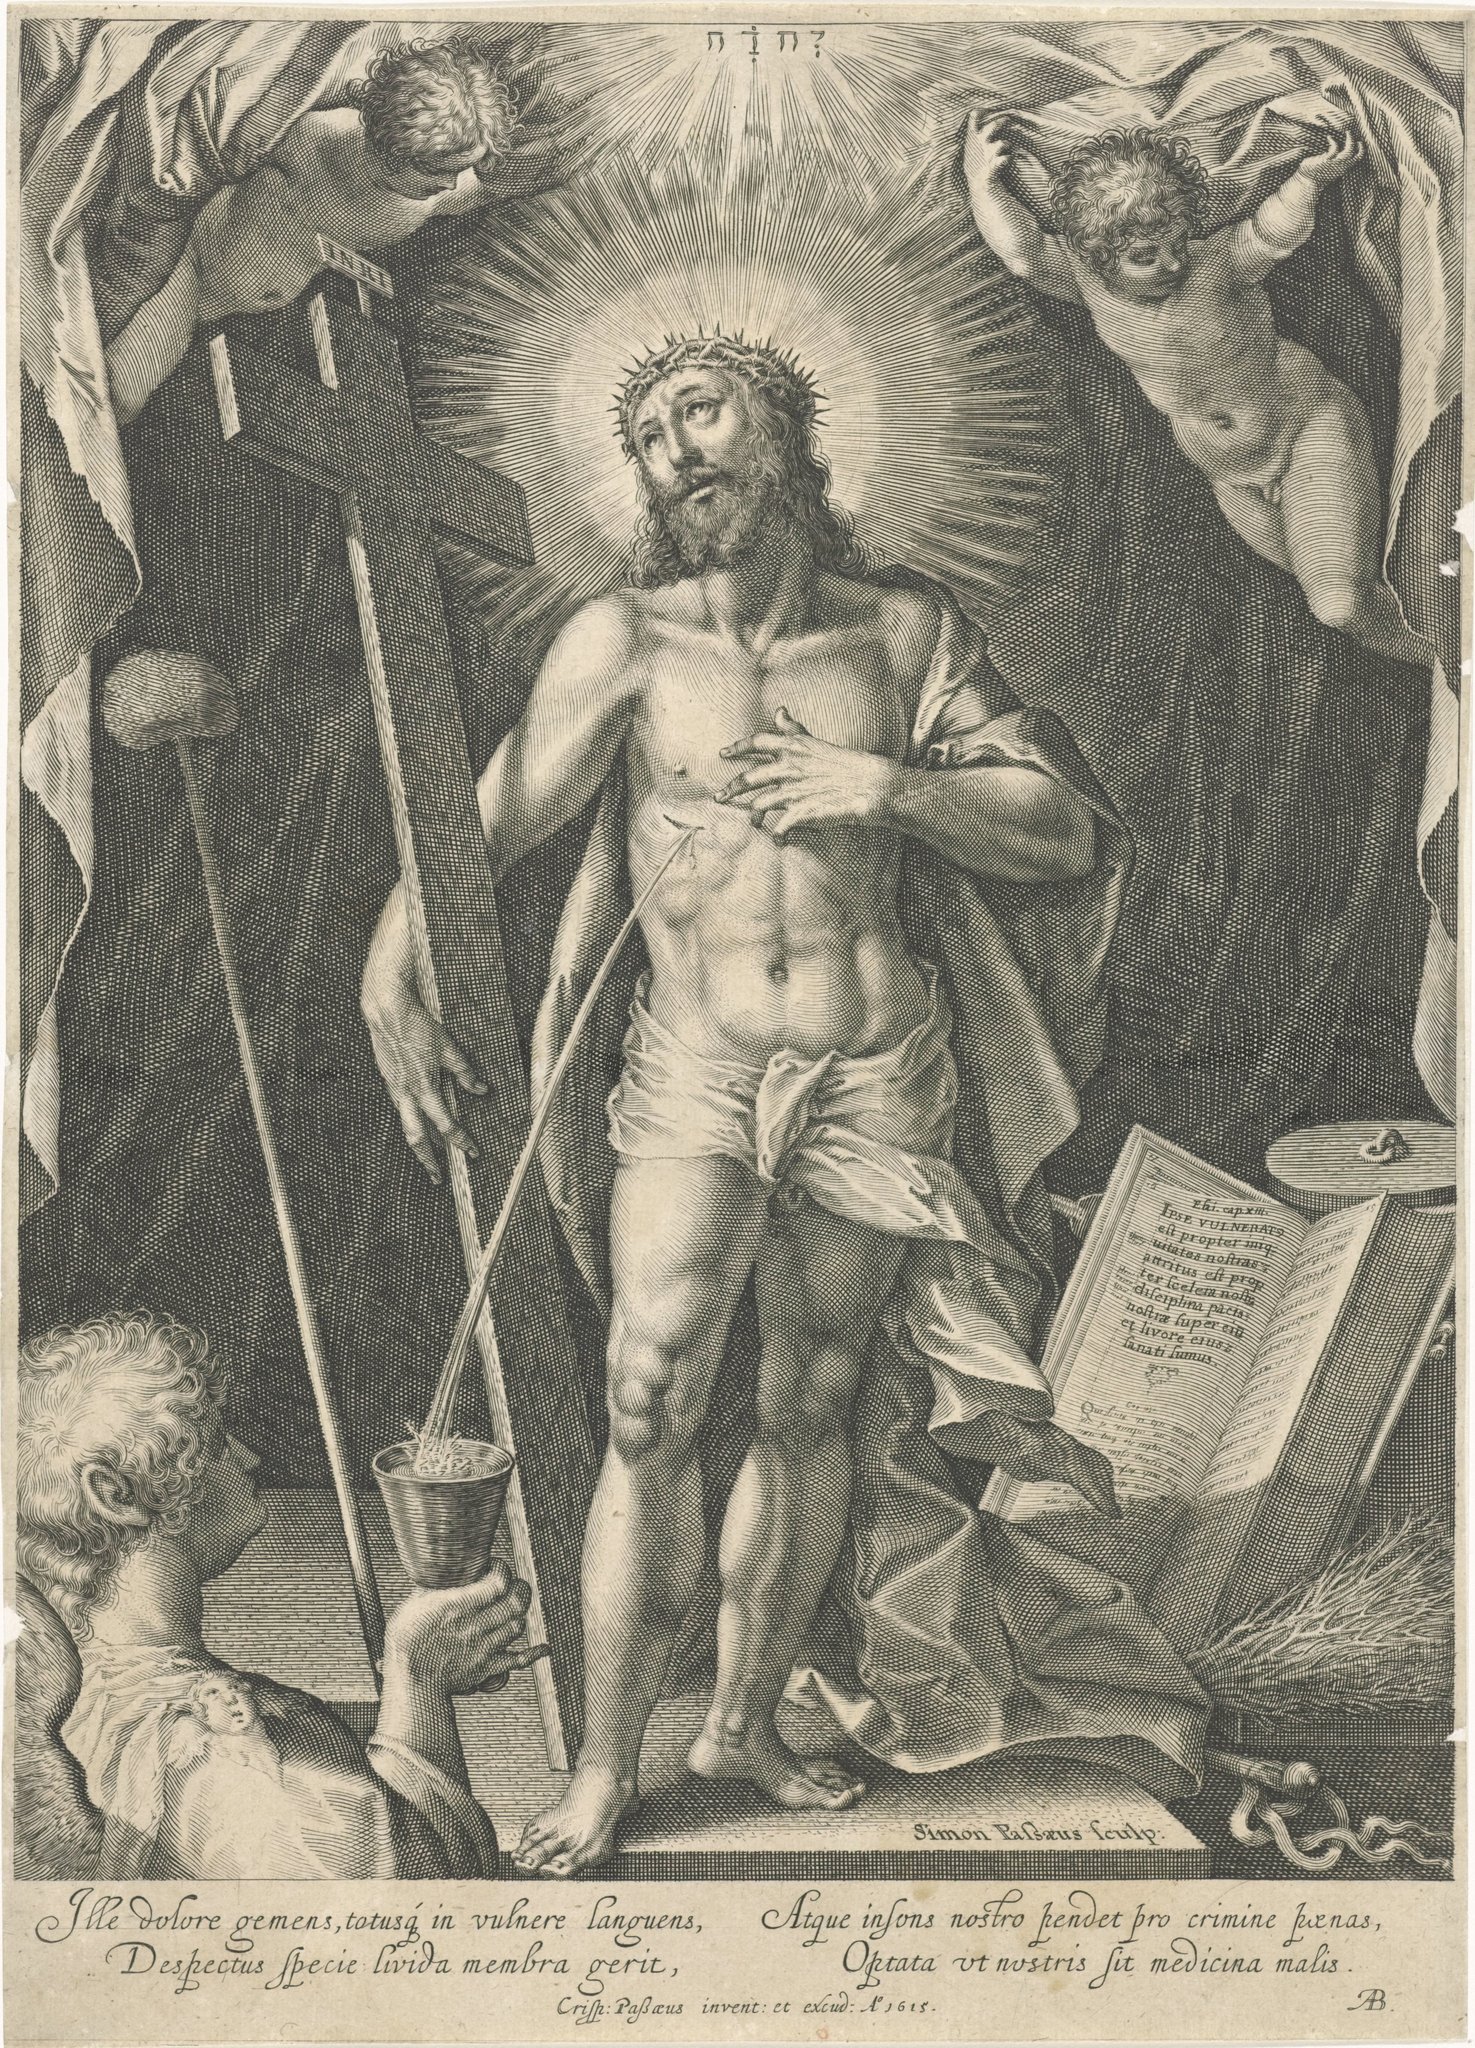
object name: print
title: Christus als Man van Smarten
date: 1615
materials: paper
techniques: engraving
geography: london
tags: man of sorrows, 'imago pietatis', 'erbärmdebild', 'schmerzensmann'; the upright christ showing his wounds, usually bearing the crown of thorns, and accompanied by the instruments of the passion, standing or sitting in his tomb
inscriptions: collector's mark: Lugt 2228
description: Christus met doornenkroon. Kruis omringd door de passiewerktuigen. Een engel vangt het bloed uit de wond in zijn zij op in een kelk. Bovenaan het tetragram met de naam van God. In de marge een vierregelig onderschrift, in twee kolommen, in het Latijn.